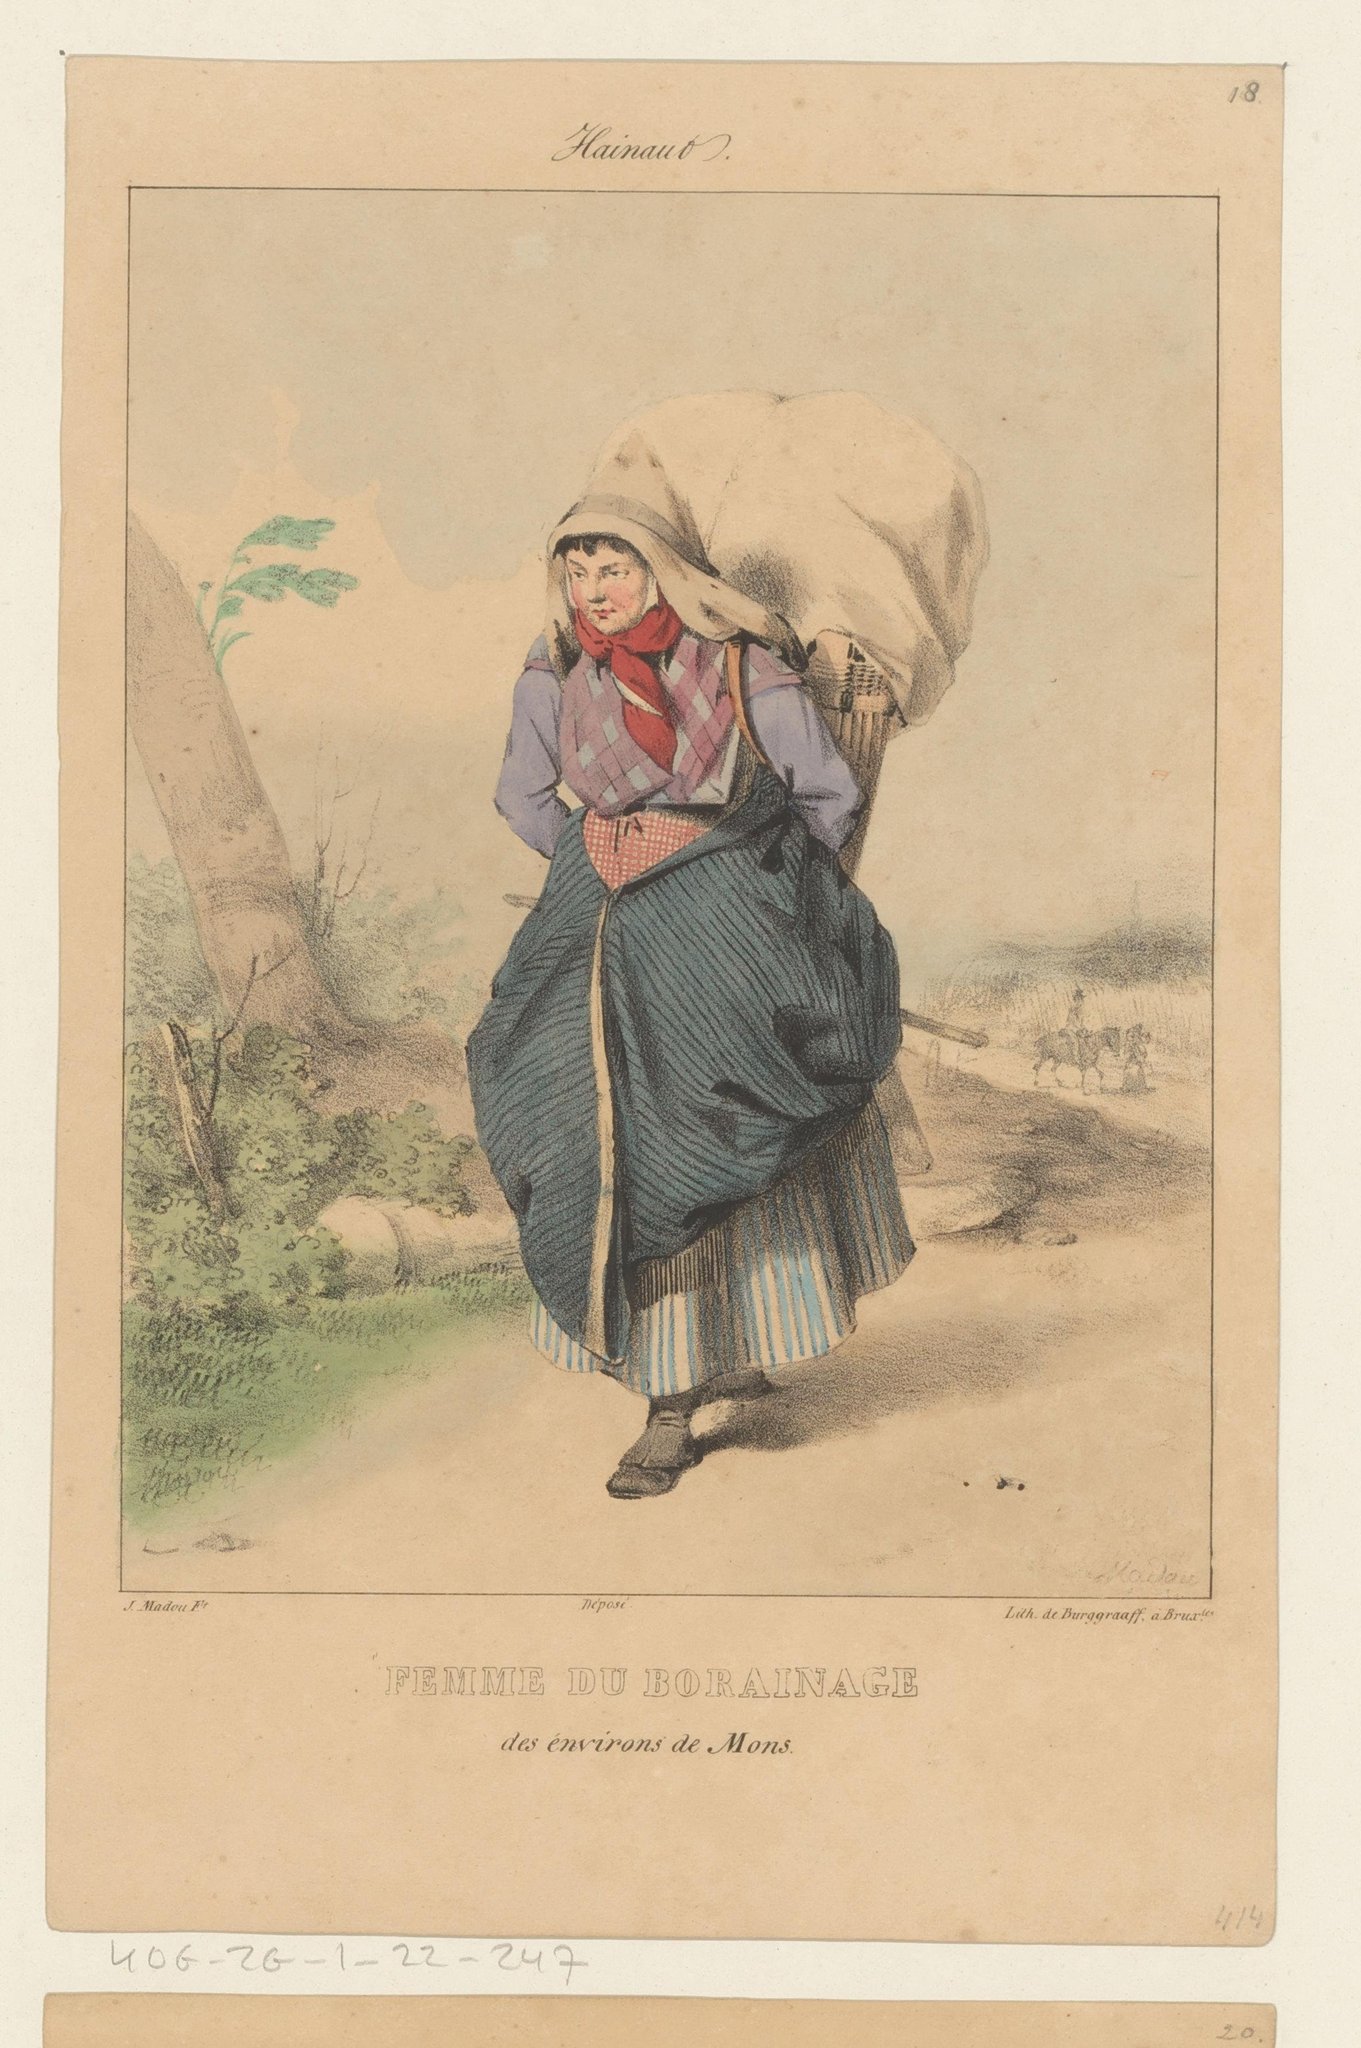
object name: print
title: Collection de costumes du peuple des provinces de la Belgique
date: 1835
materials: paper, watercolor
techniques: hand coloring, lithograph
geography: belgium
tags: clothes, costume (+ women's clothes), carrying something in basket, bag, rucksack, etc., folk costume, regional costume, southern netherlands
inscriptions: collector's mark, collector's mark: Lugt 1641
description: Van den Burggraaff wilde een serie (twintig afleveringen met telkens vier platen) uitgeven met kostuums uit alle provincies van Nederland en België onder de titel 'Costumes du peuple de toutes les provinces des Pays-Bas'. Hij begint met deze serie in 1825 en eindigt hiermee bij de dertiende aflevering in 1830. Omdat in 1830 België zich afsplitst van Nederland geeft hij de prenten daarna apart uit onder de titels 'Costumes de peuple Hollandais' en 'Collection de costumes du peuple des provinces de la Belgique' (1835).